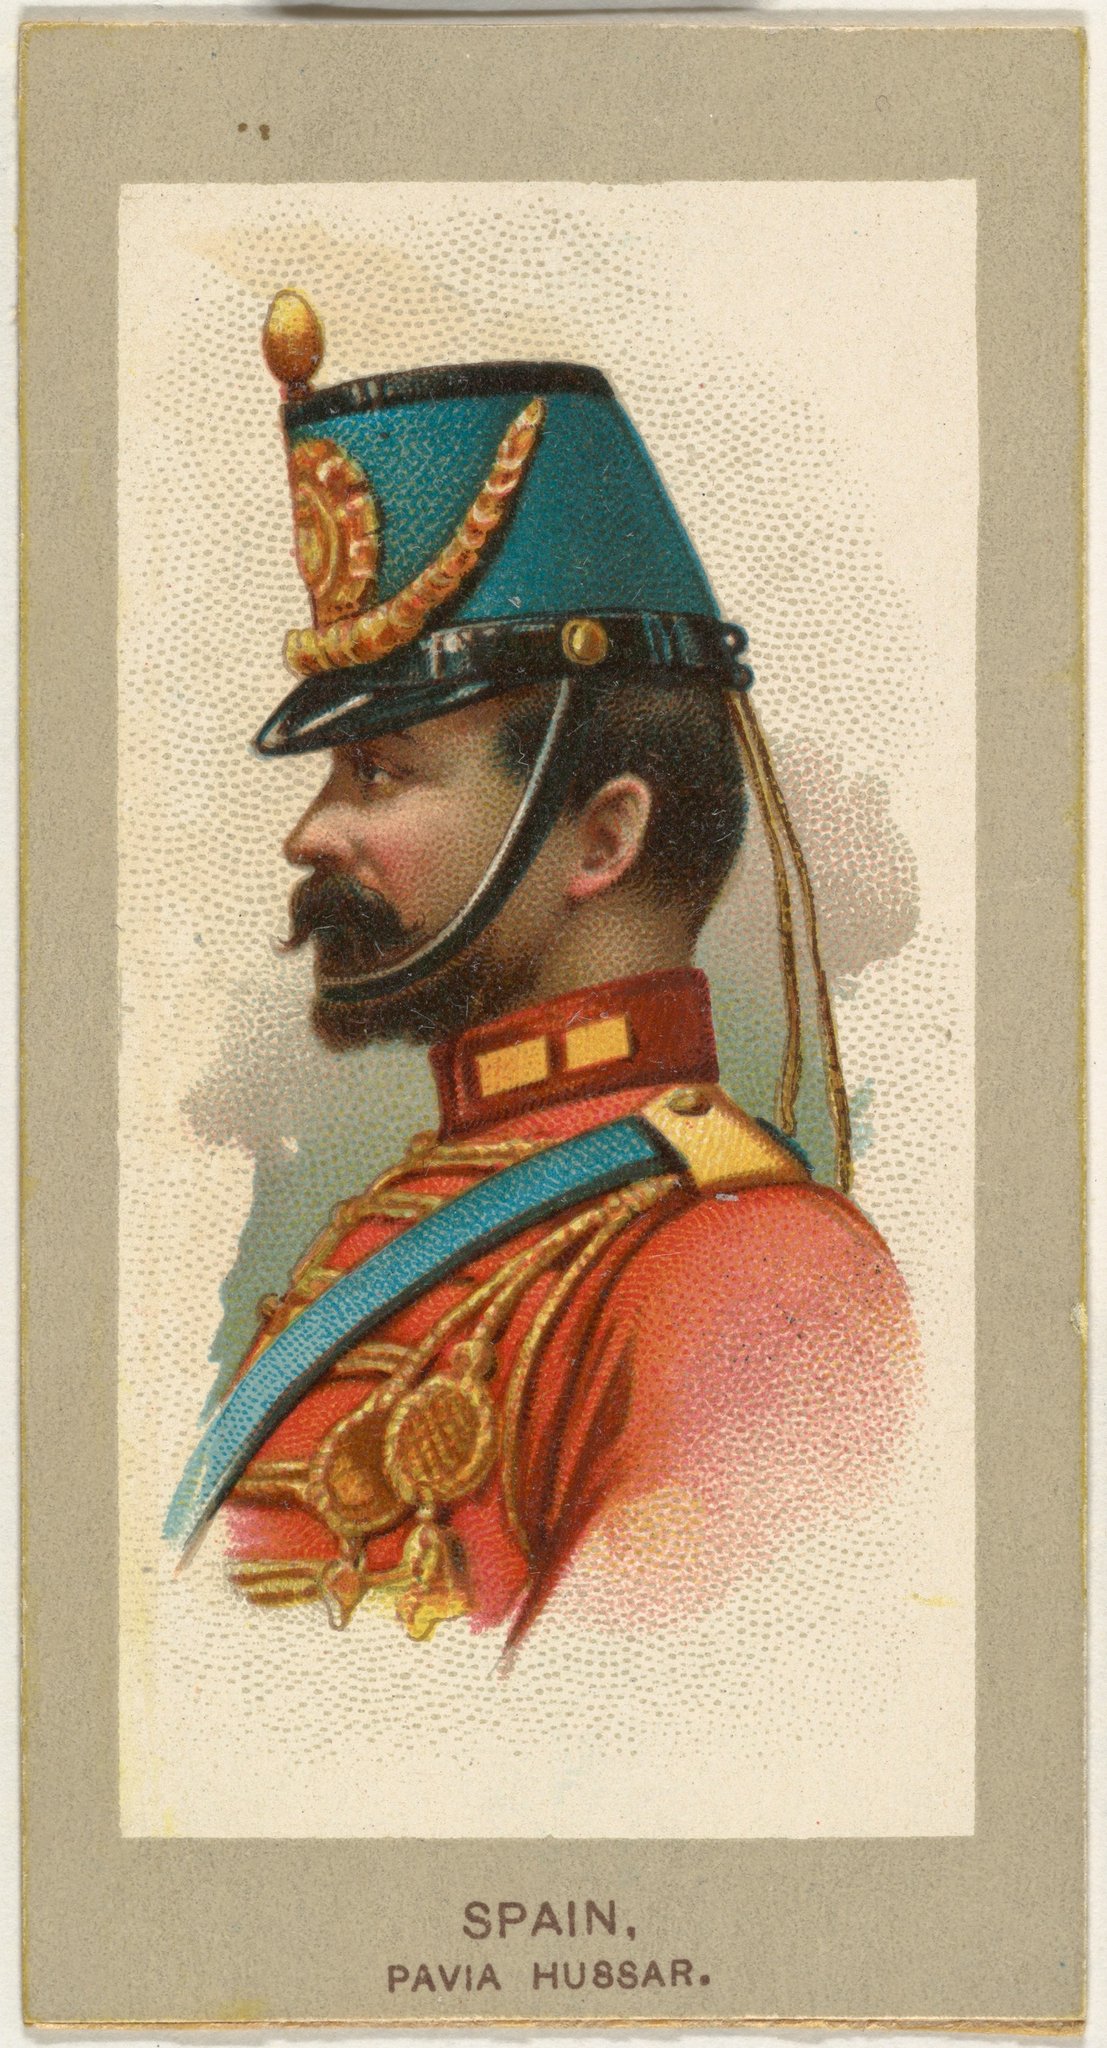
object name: print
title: Pavia Hussar, Spain, from the Military Uniforms series (T182) issued by Abdul Cigarettes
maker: abdul cigarettes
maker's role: publisher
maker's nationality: american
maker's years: 1881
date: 1881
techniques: color lithograph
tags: soldiers,military clothing,profiles